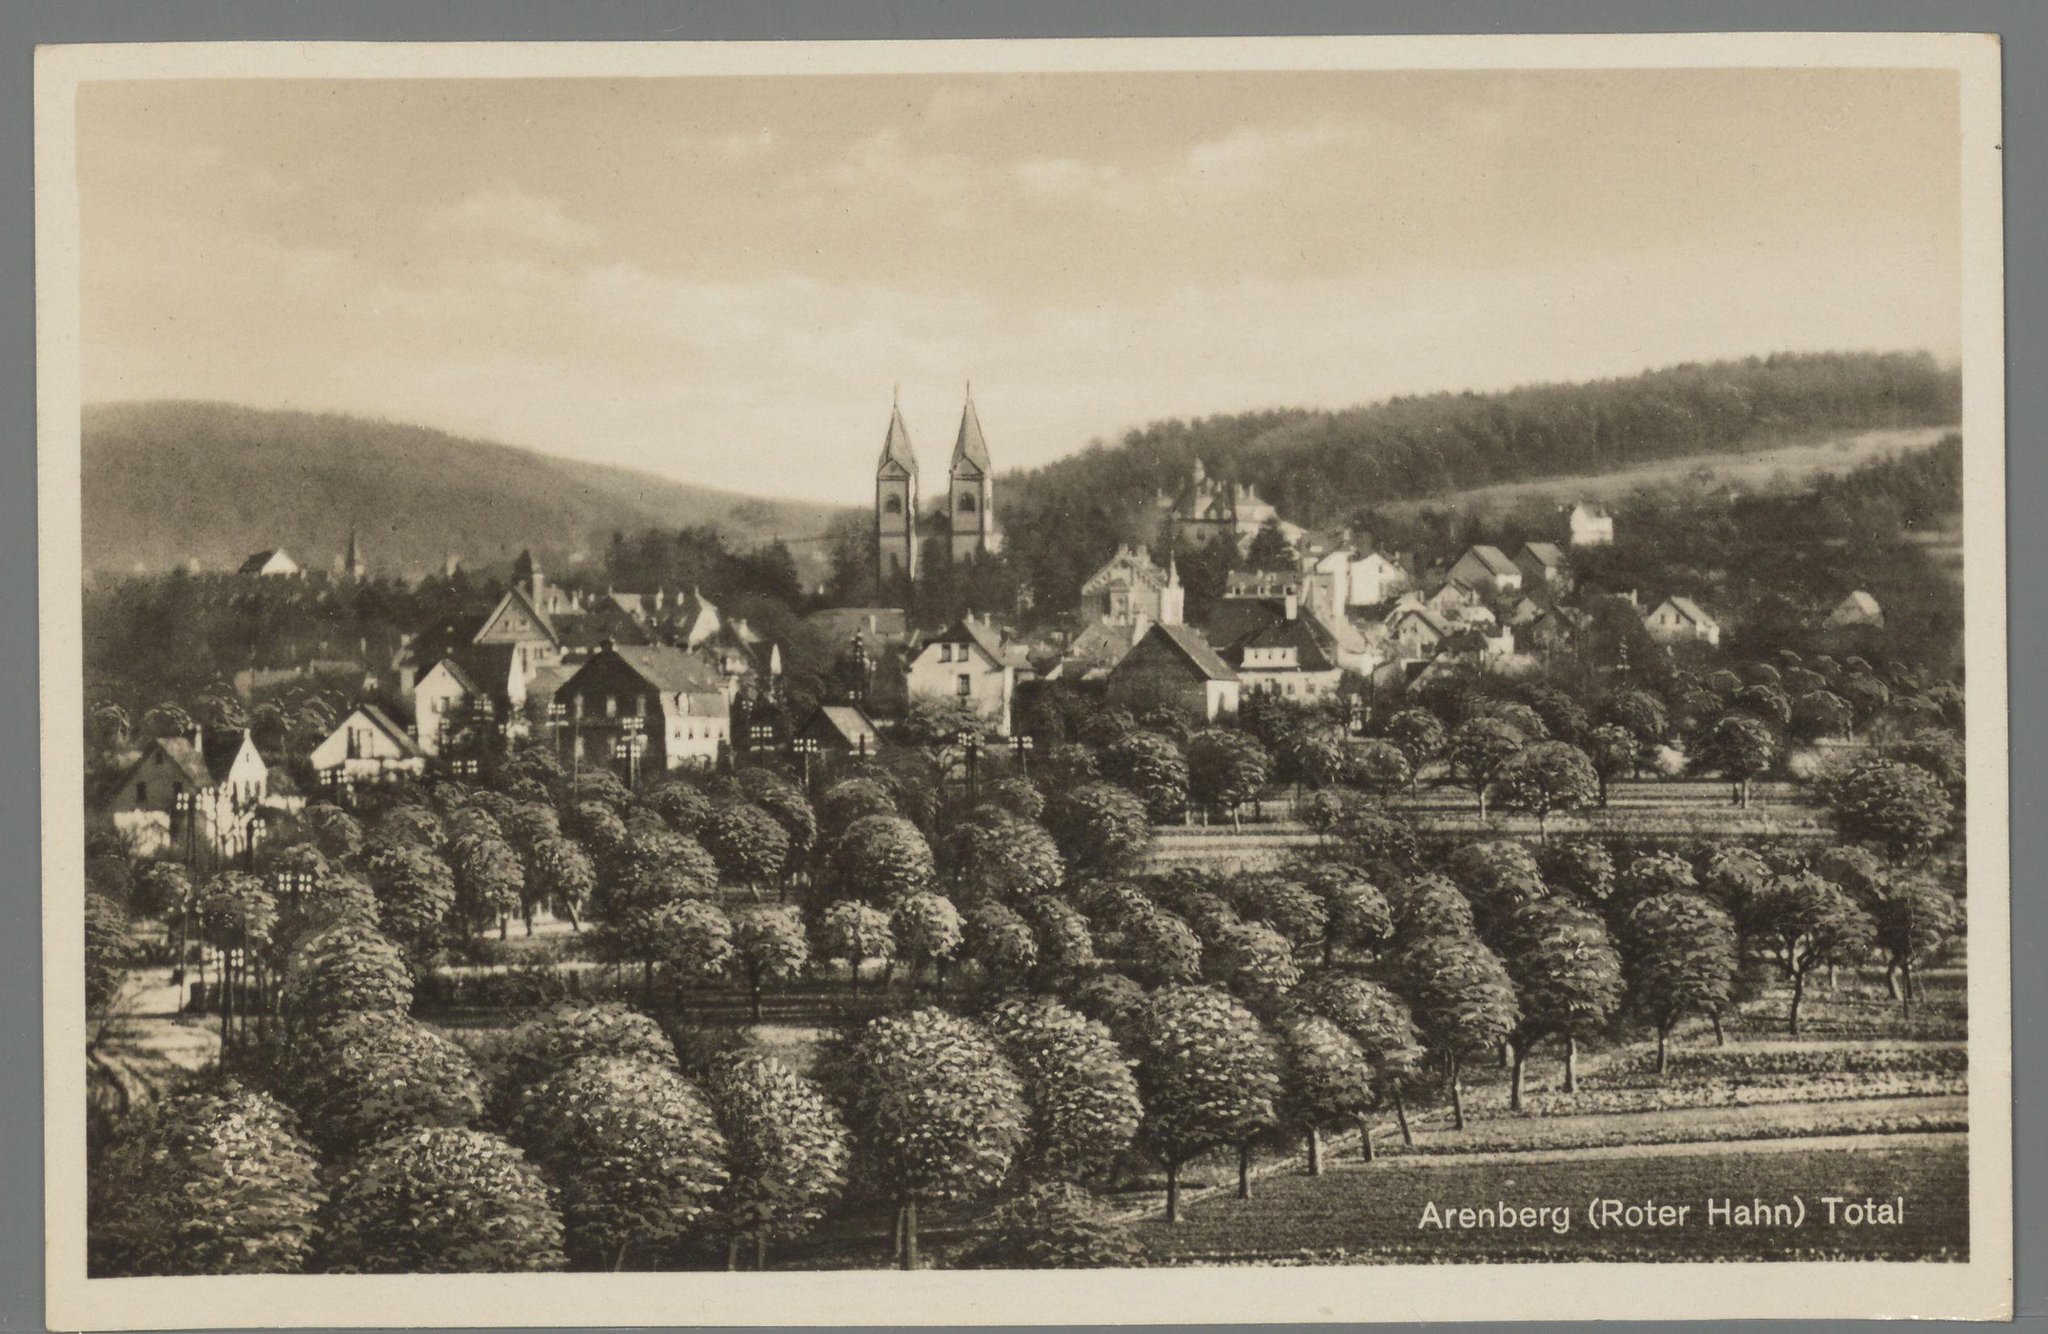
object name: photograph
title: Arenberg (Roter Hahn) Total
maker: fritz wagner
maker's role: fotograaf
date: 1907-1921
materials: photographic support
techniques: photography, writing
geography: weis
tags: city-view, and landscape with man-made constructions, church (exterior), mountains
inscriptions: date